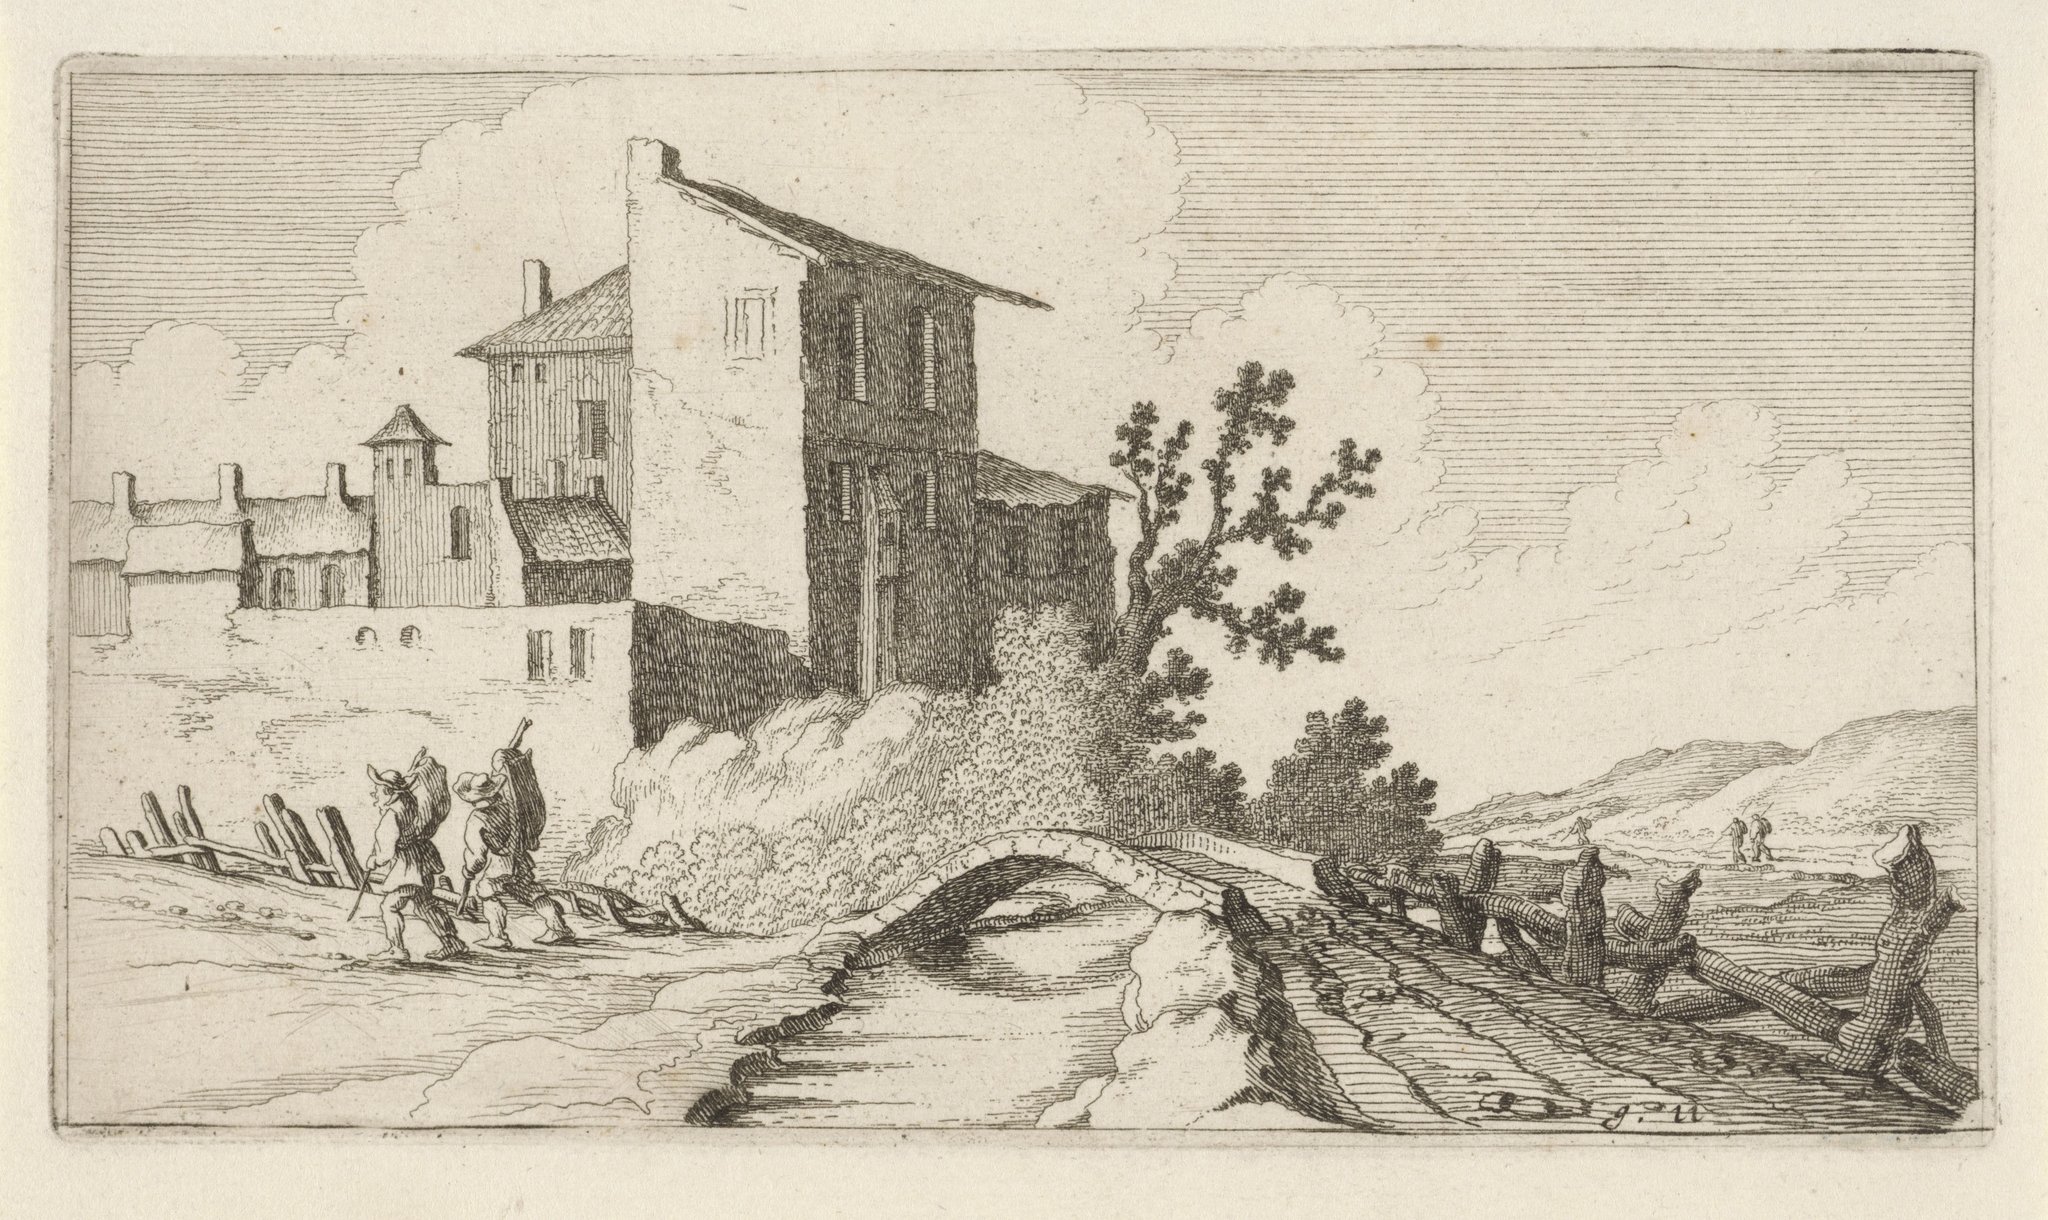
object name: print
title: Twaalf landschappen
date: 1640-1706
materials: paper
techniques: etching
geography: amsterdam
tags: village, bridge, 'en route', traveller under way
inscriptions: collector's mark: Lugt 2165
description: In een heuvelachtig landschap ligt een stenen brug voor een groep ommuurde gebouwen. Twee reizigers lopen over een landweg langs de muur. De prent maakt deel uit van een serie van twaalf landschappen.